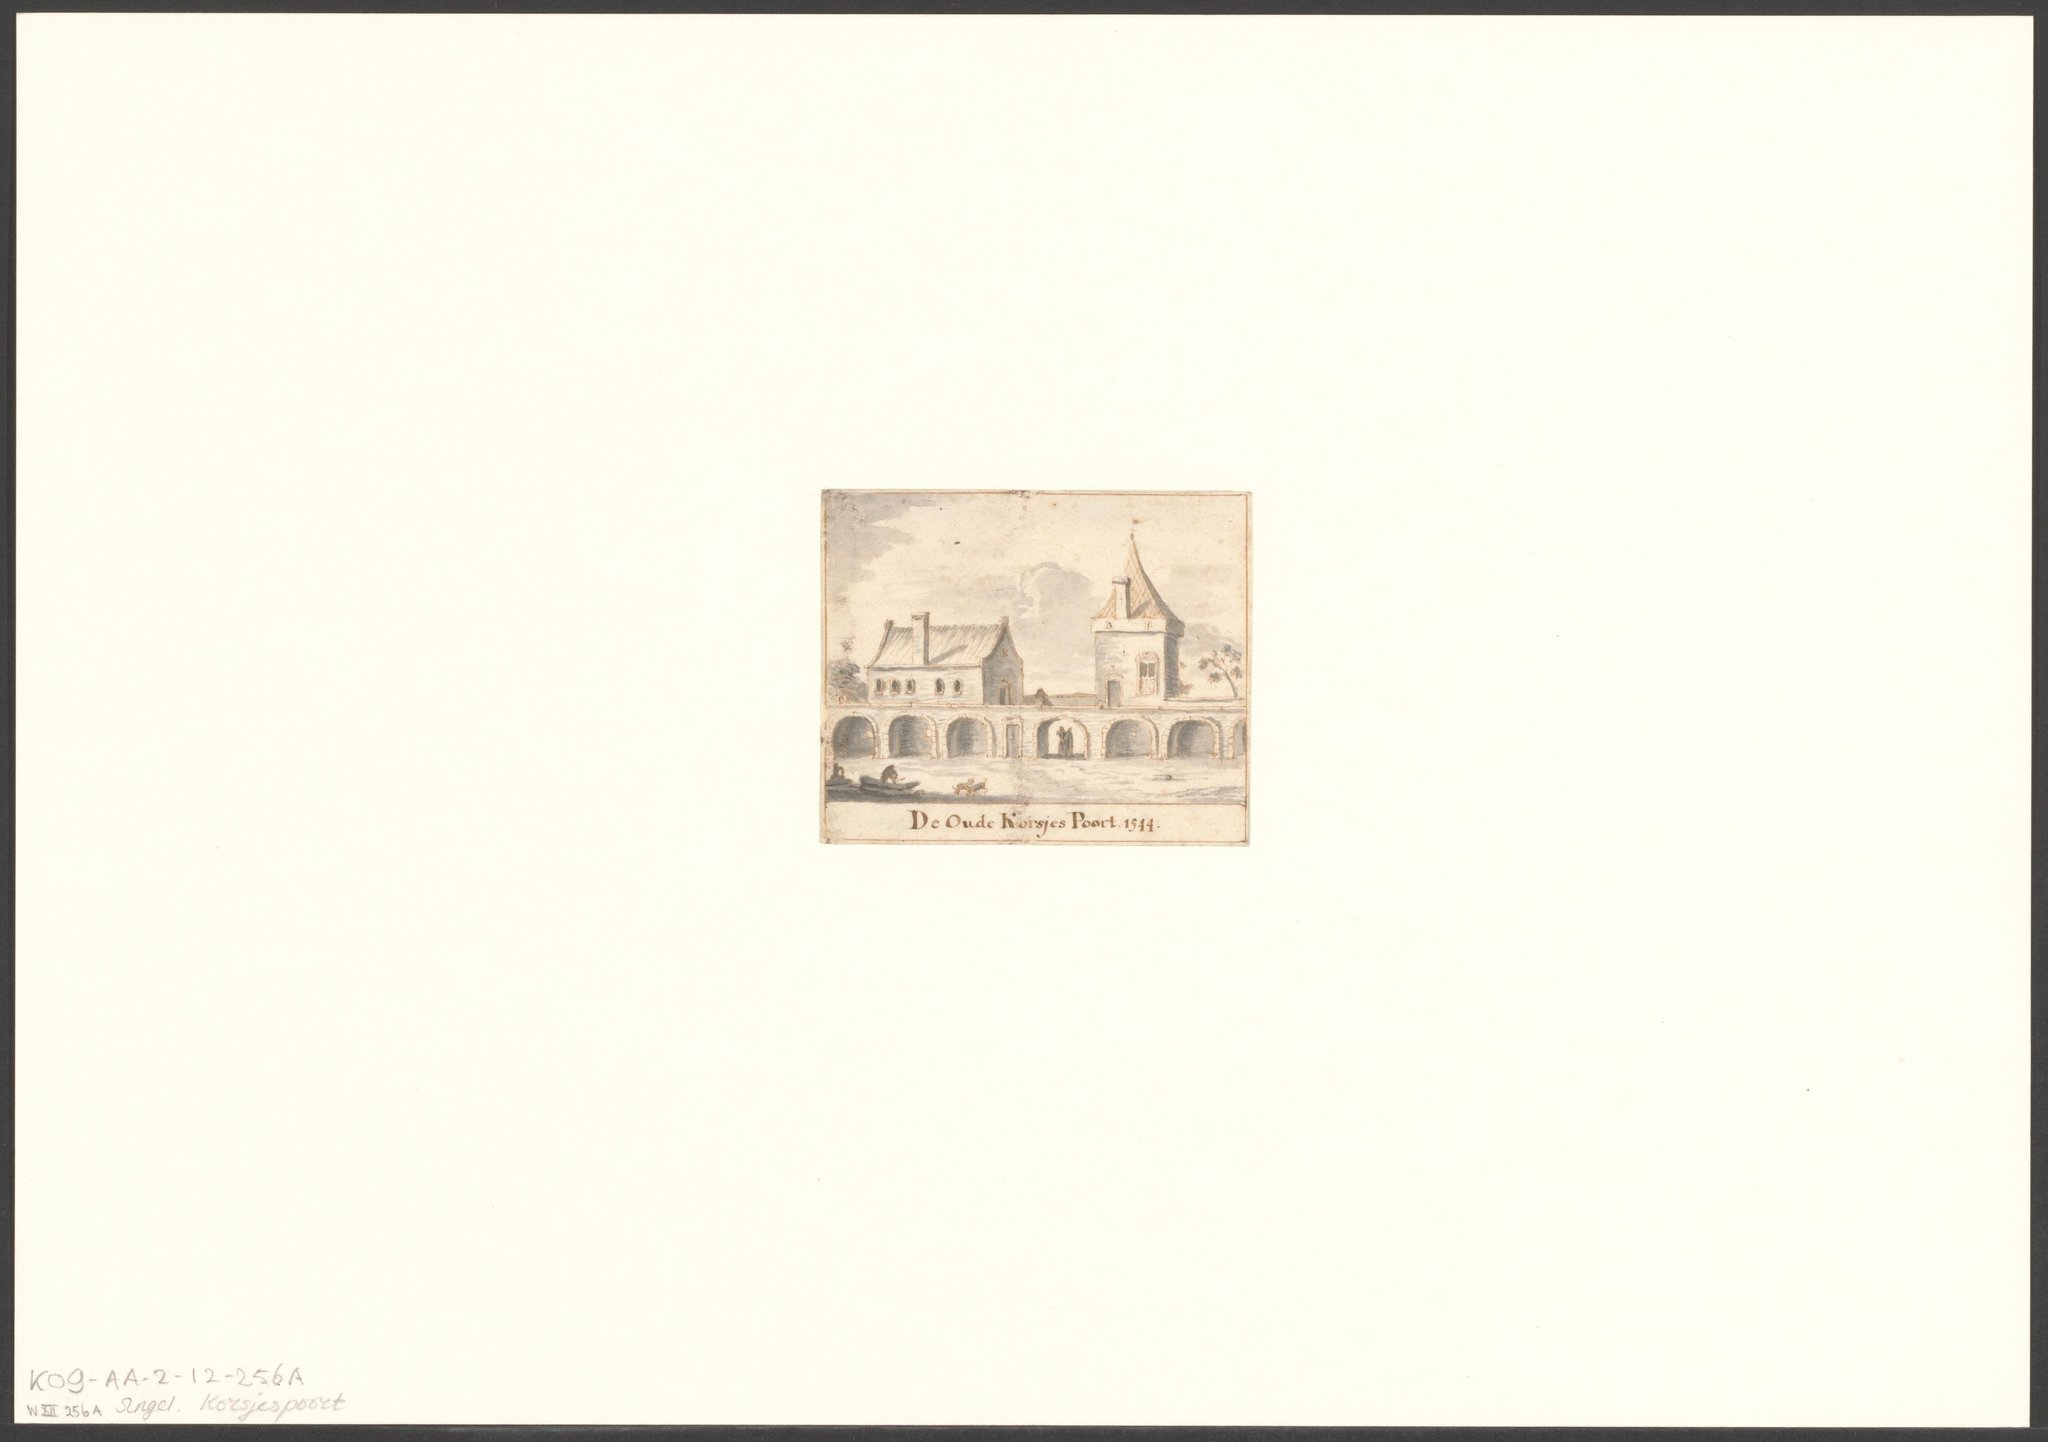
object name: drawing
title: Gezicht op de Korsjespoort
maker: Anonymous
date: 1723-1799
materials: ink, paper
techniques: brush, pen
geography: amsterdam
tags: city-view, and landscape with man-made constructions, river, city-gate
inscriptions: inscription: ‘De Oude Korsjes Poort.1544.’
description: Tekening binnen de Atlas Van Eck ingedeeld op wijknummer 12.